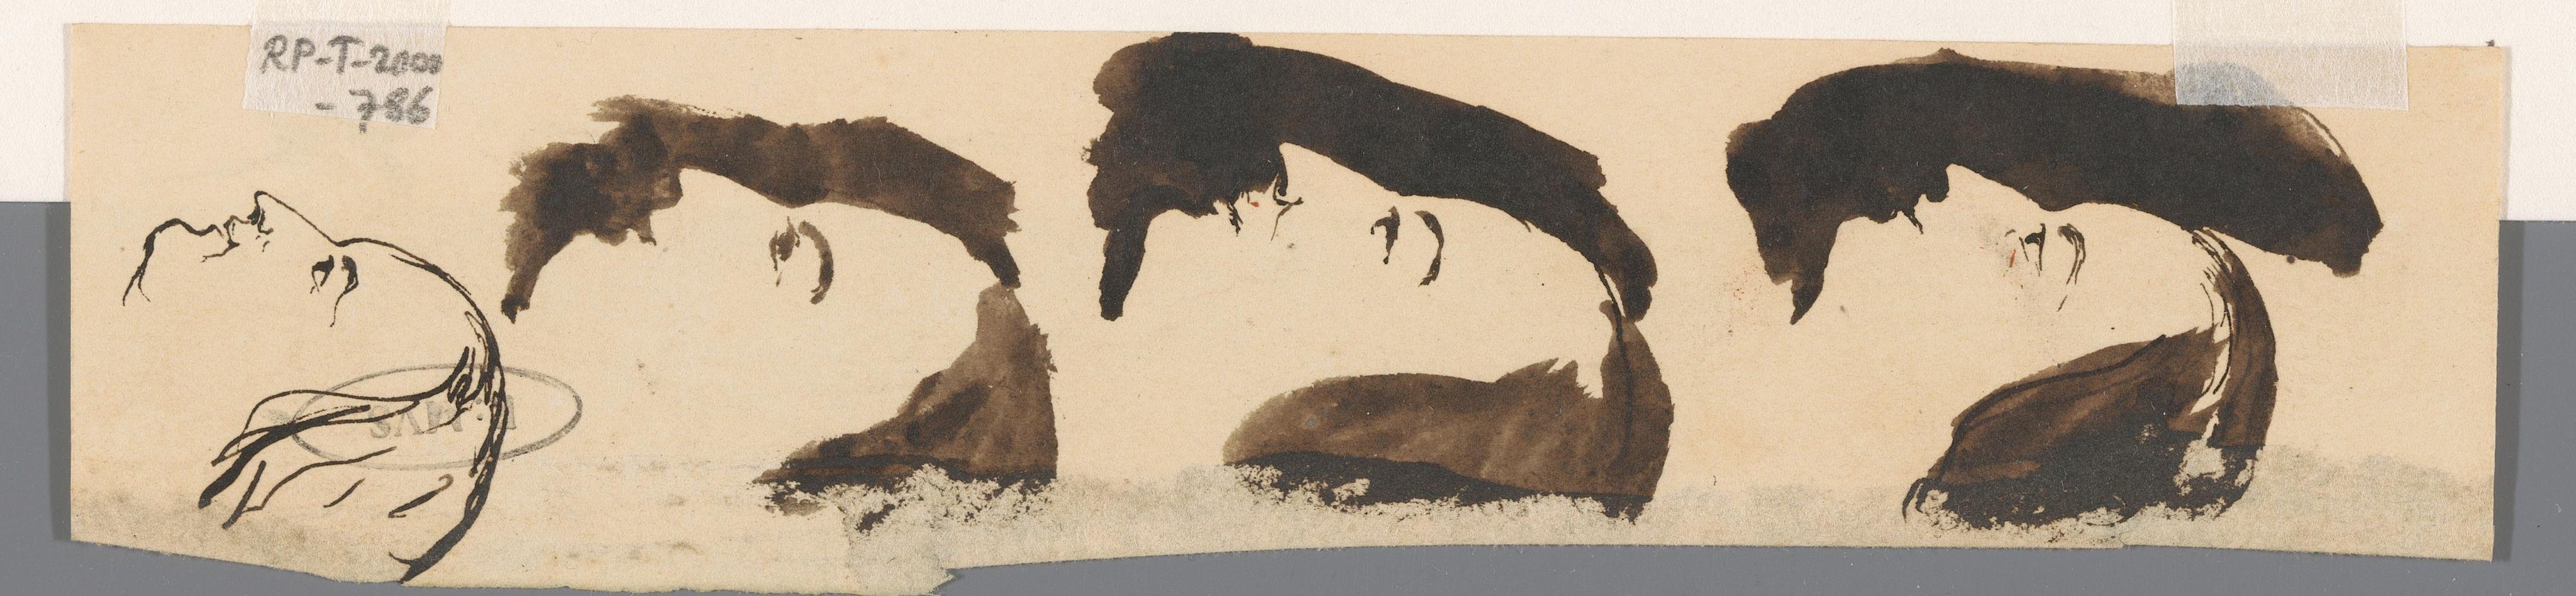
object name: drawing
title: Vier profielen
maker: johannes tavenraat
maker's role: draughtsman, painter, print maker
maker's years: 1809-1881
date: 1840-1880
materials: ink, paper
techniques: brush, pen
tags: head (human) (+ sideview, profile)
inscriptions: collector's mark: Lugt 2228